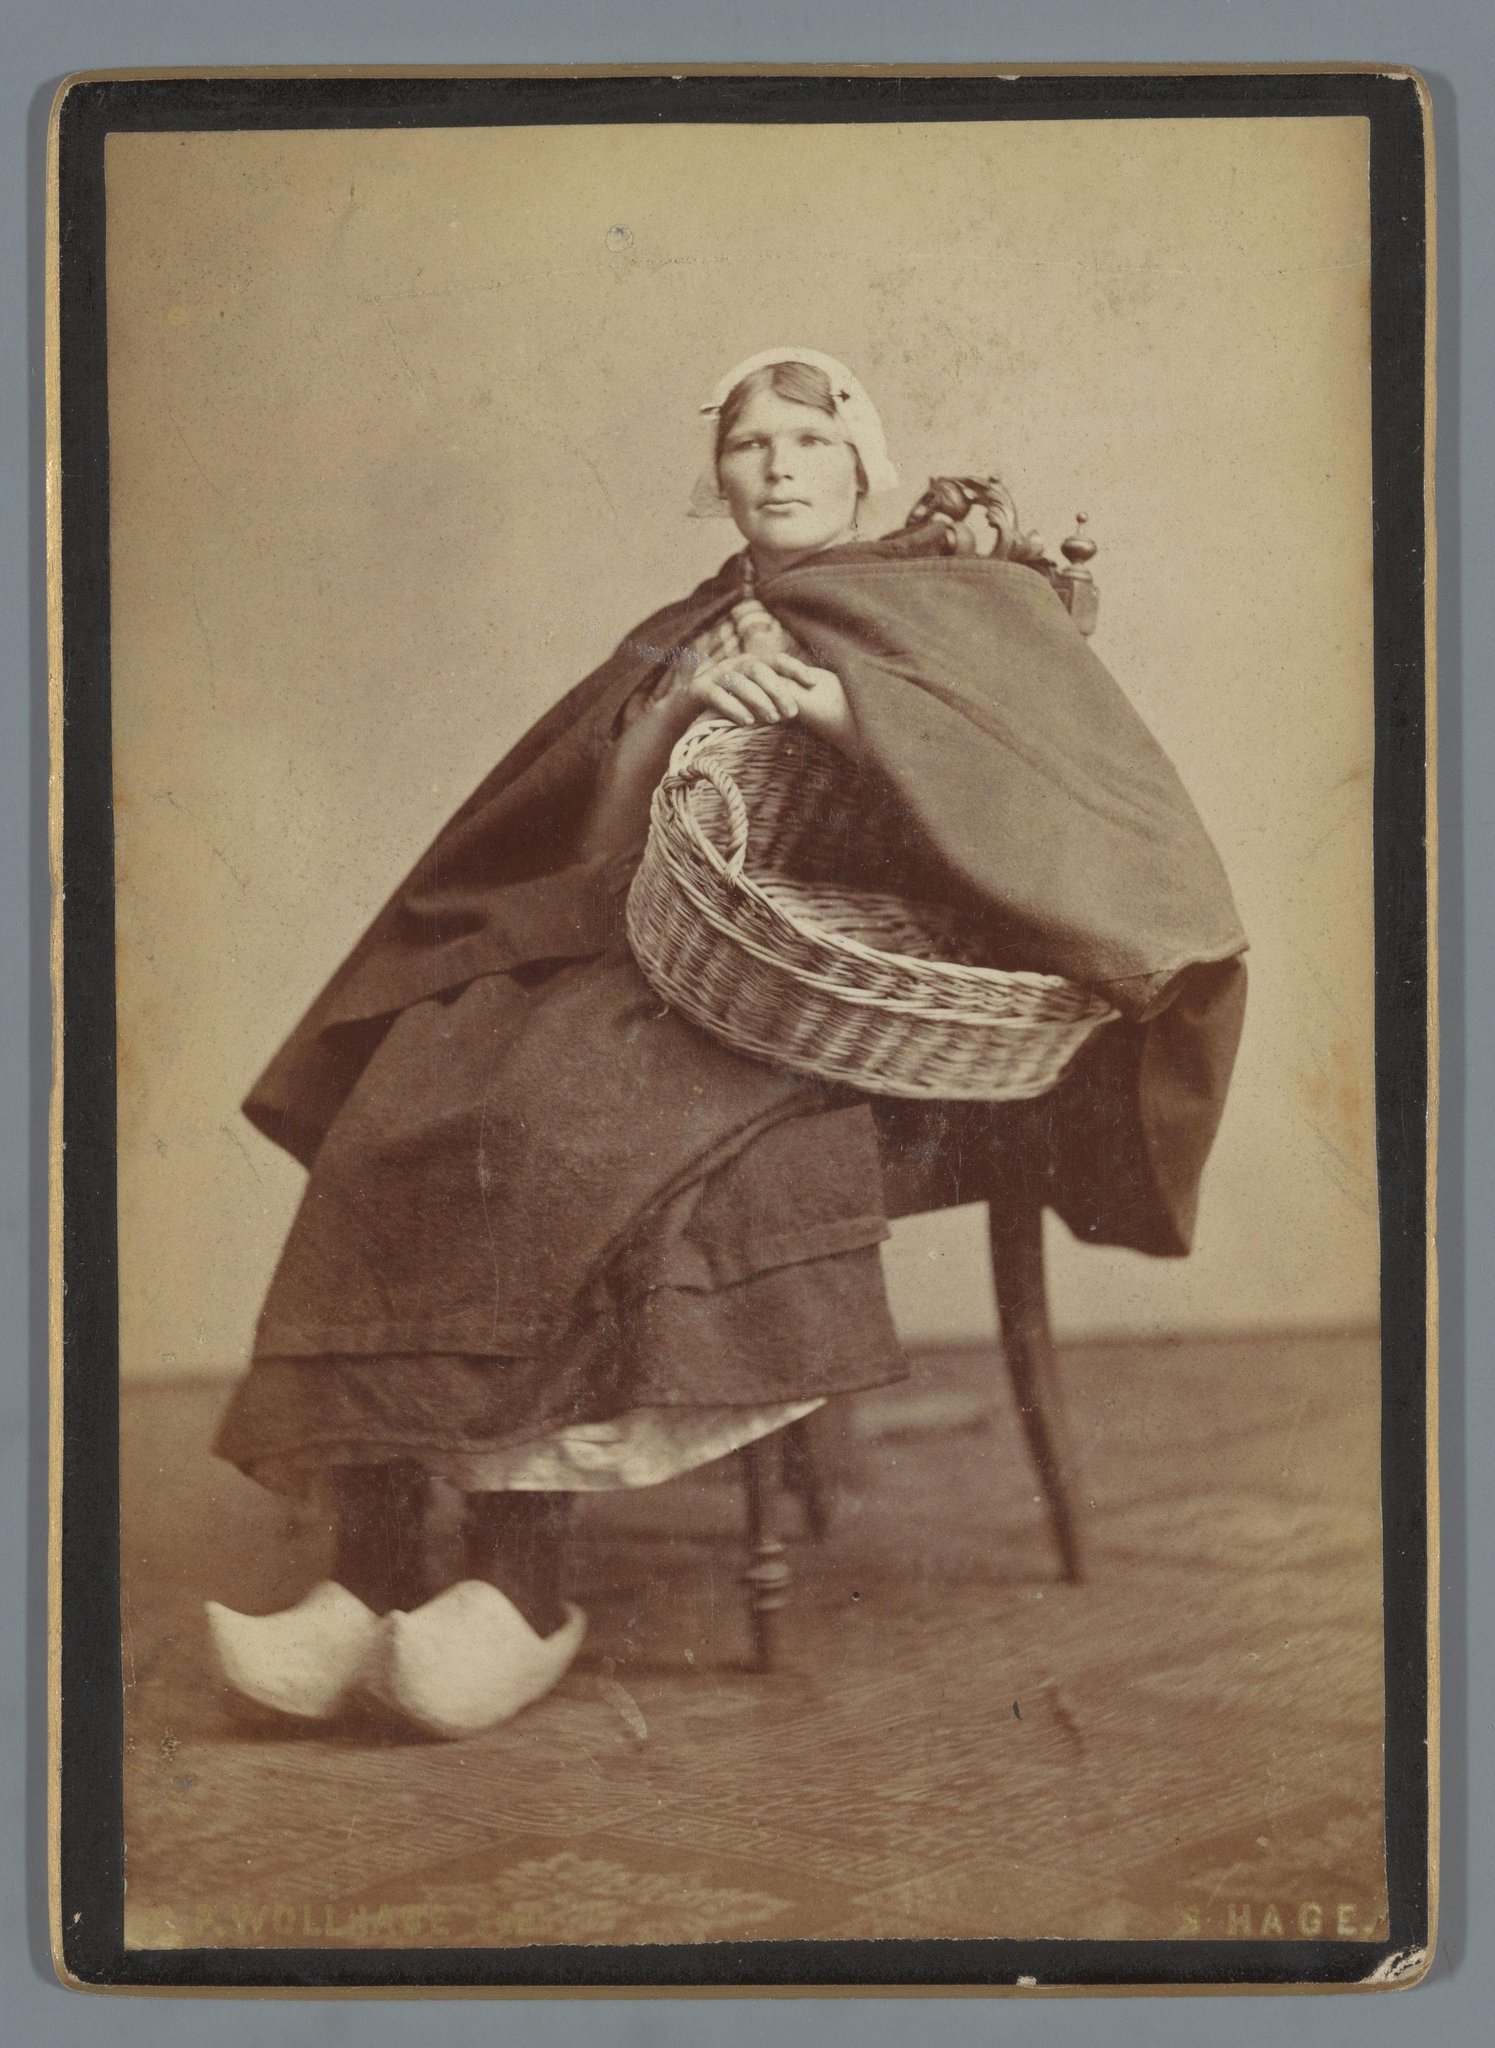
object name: photograph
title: Portret van een onbekende vrouw in Scheveningse klederdracht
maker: carl philip wollrabe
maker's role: fotograaf, musicus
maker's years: 1812-1887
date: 1885-1900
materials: cardboard, photographic support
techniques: albumen print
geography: south holland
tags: adult woman, wooden shoes, clogs, container made of plant material other than wood: basket, folk costume, regional costume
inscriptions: inscription: ‘C.P. Wollrabe sen. (...) De plaat blijft tot nabestelling bewaard.’